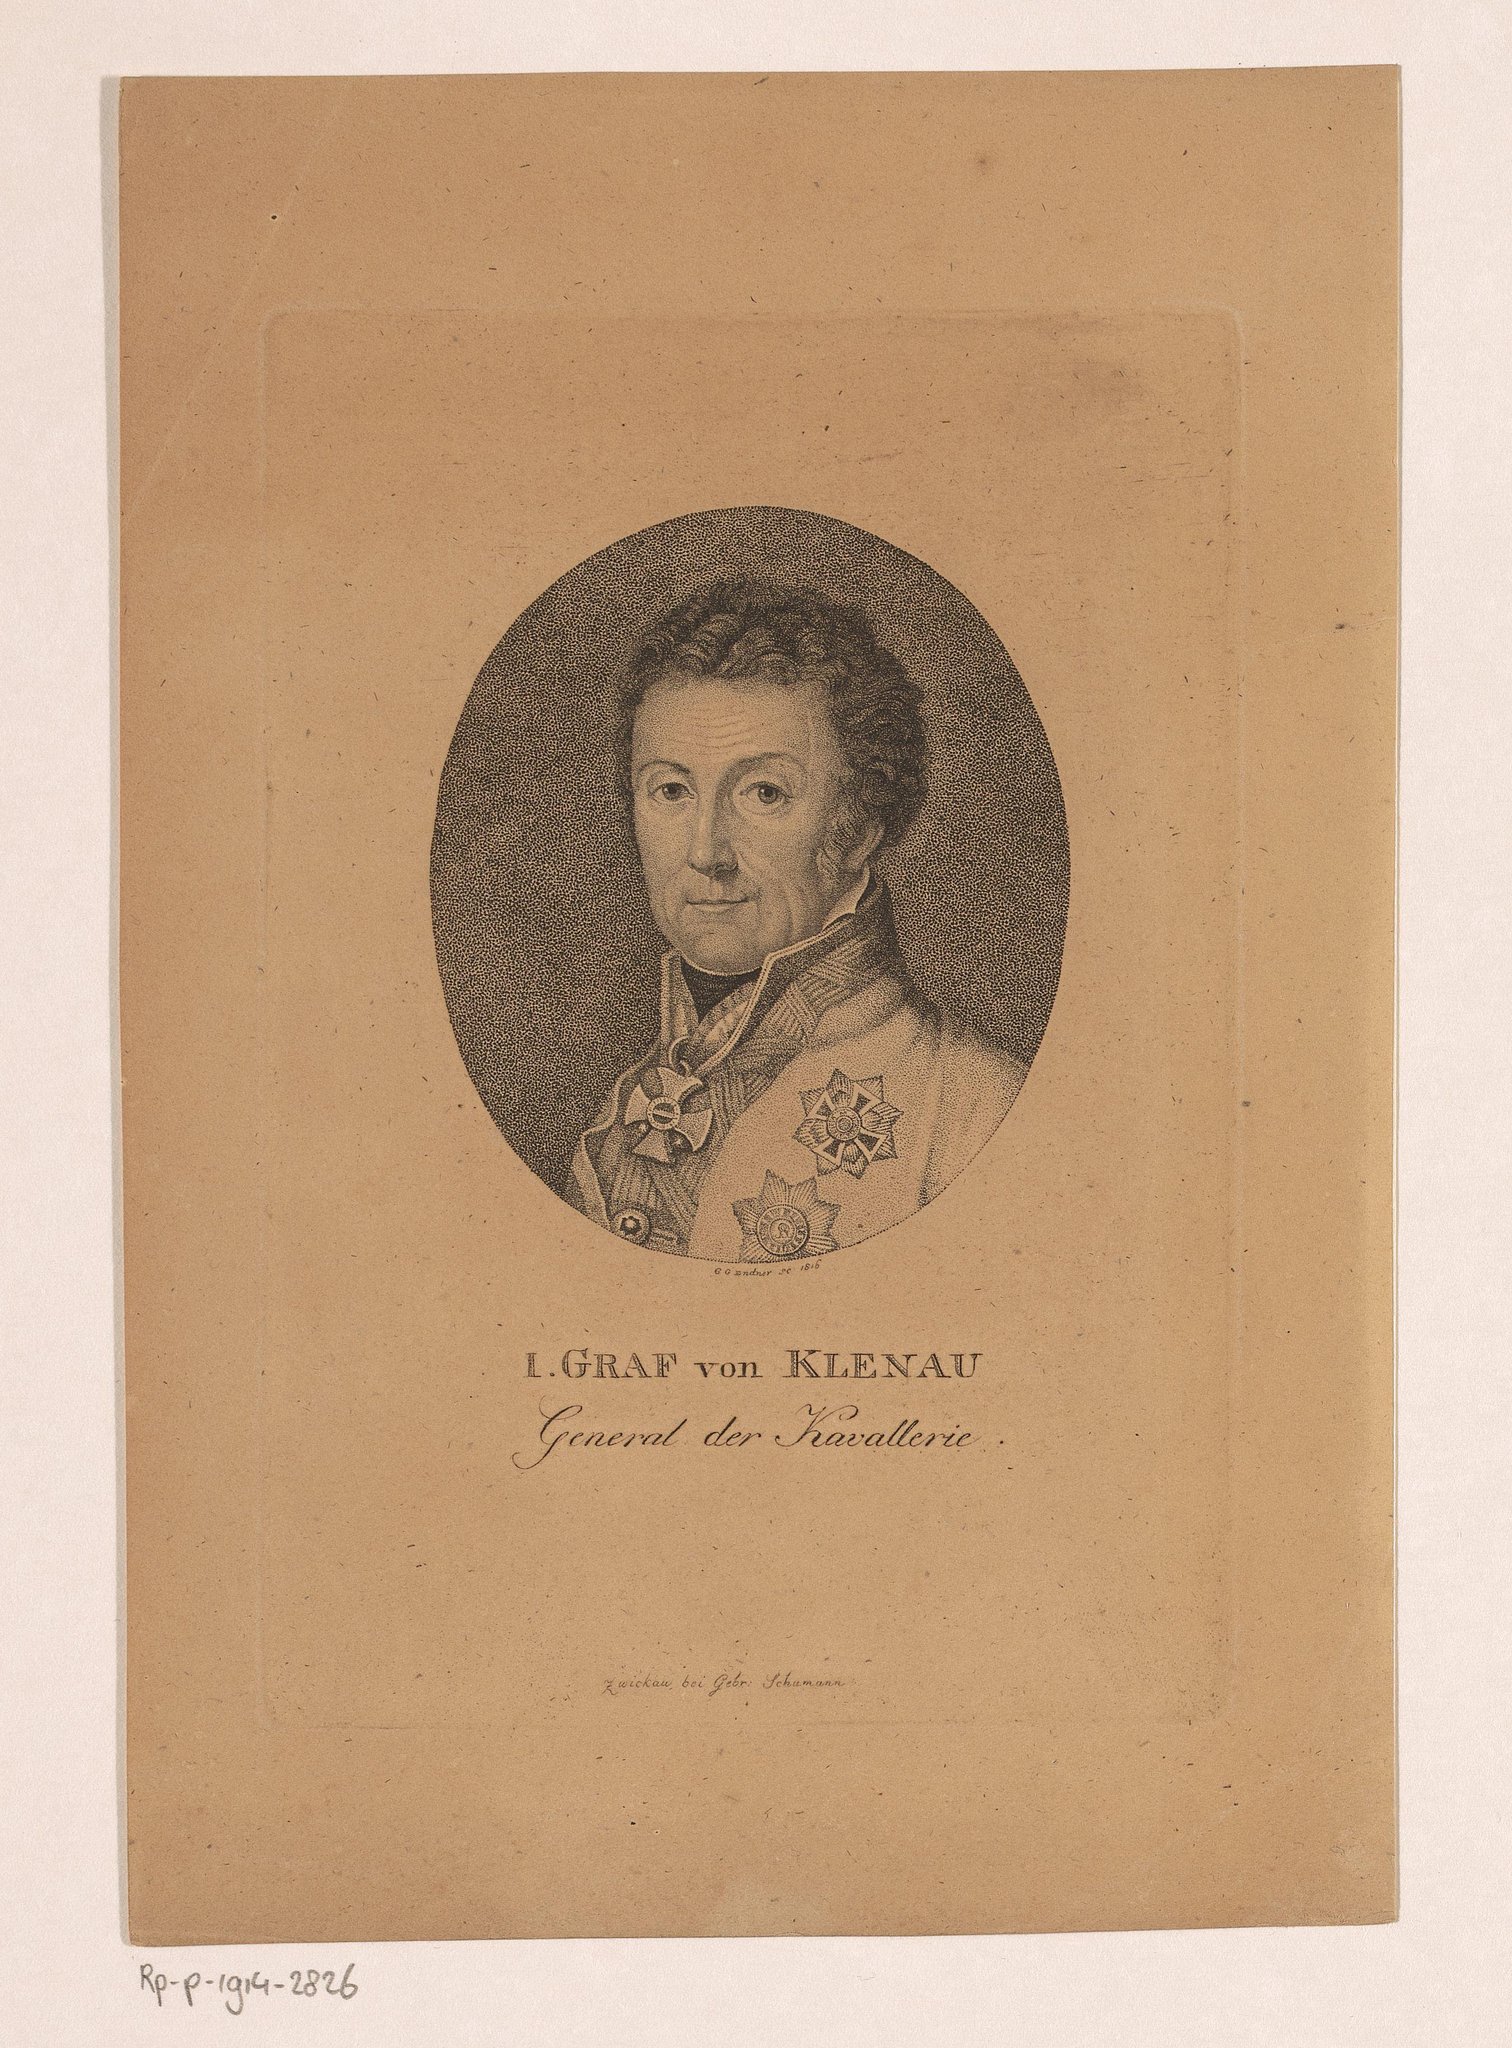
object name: print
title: Portret van Johann Graf Klenau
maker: gustav georg endner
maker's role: print maker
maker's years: 1754-1824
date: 1816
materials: paper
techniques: stippling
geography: zwickau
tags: prague, knighthood order, historical persons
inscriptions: collector's mark: Lugt 2228